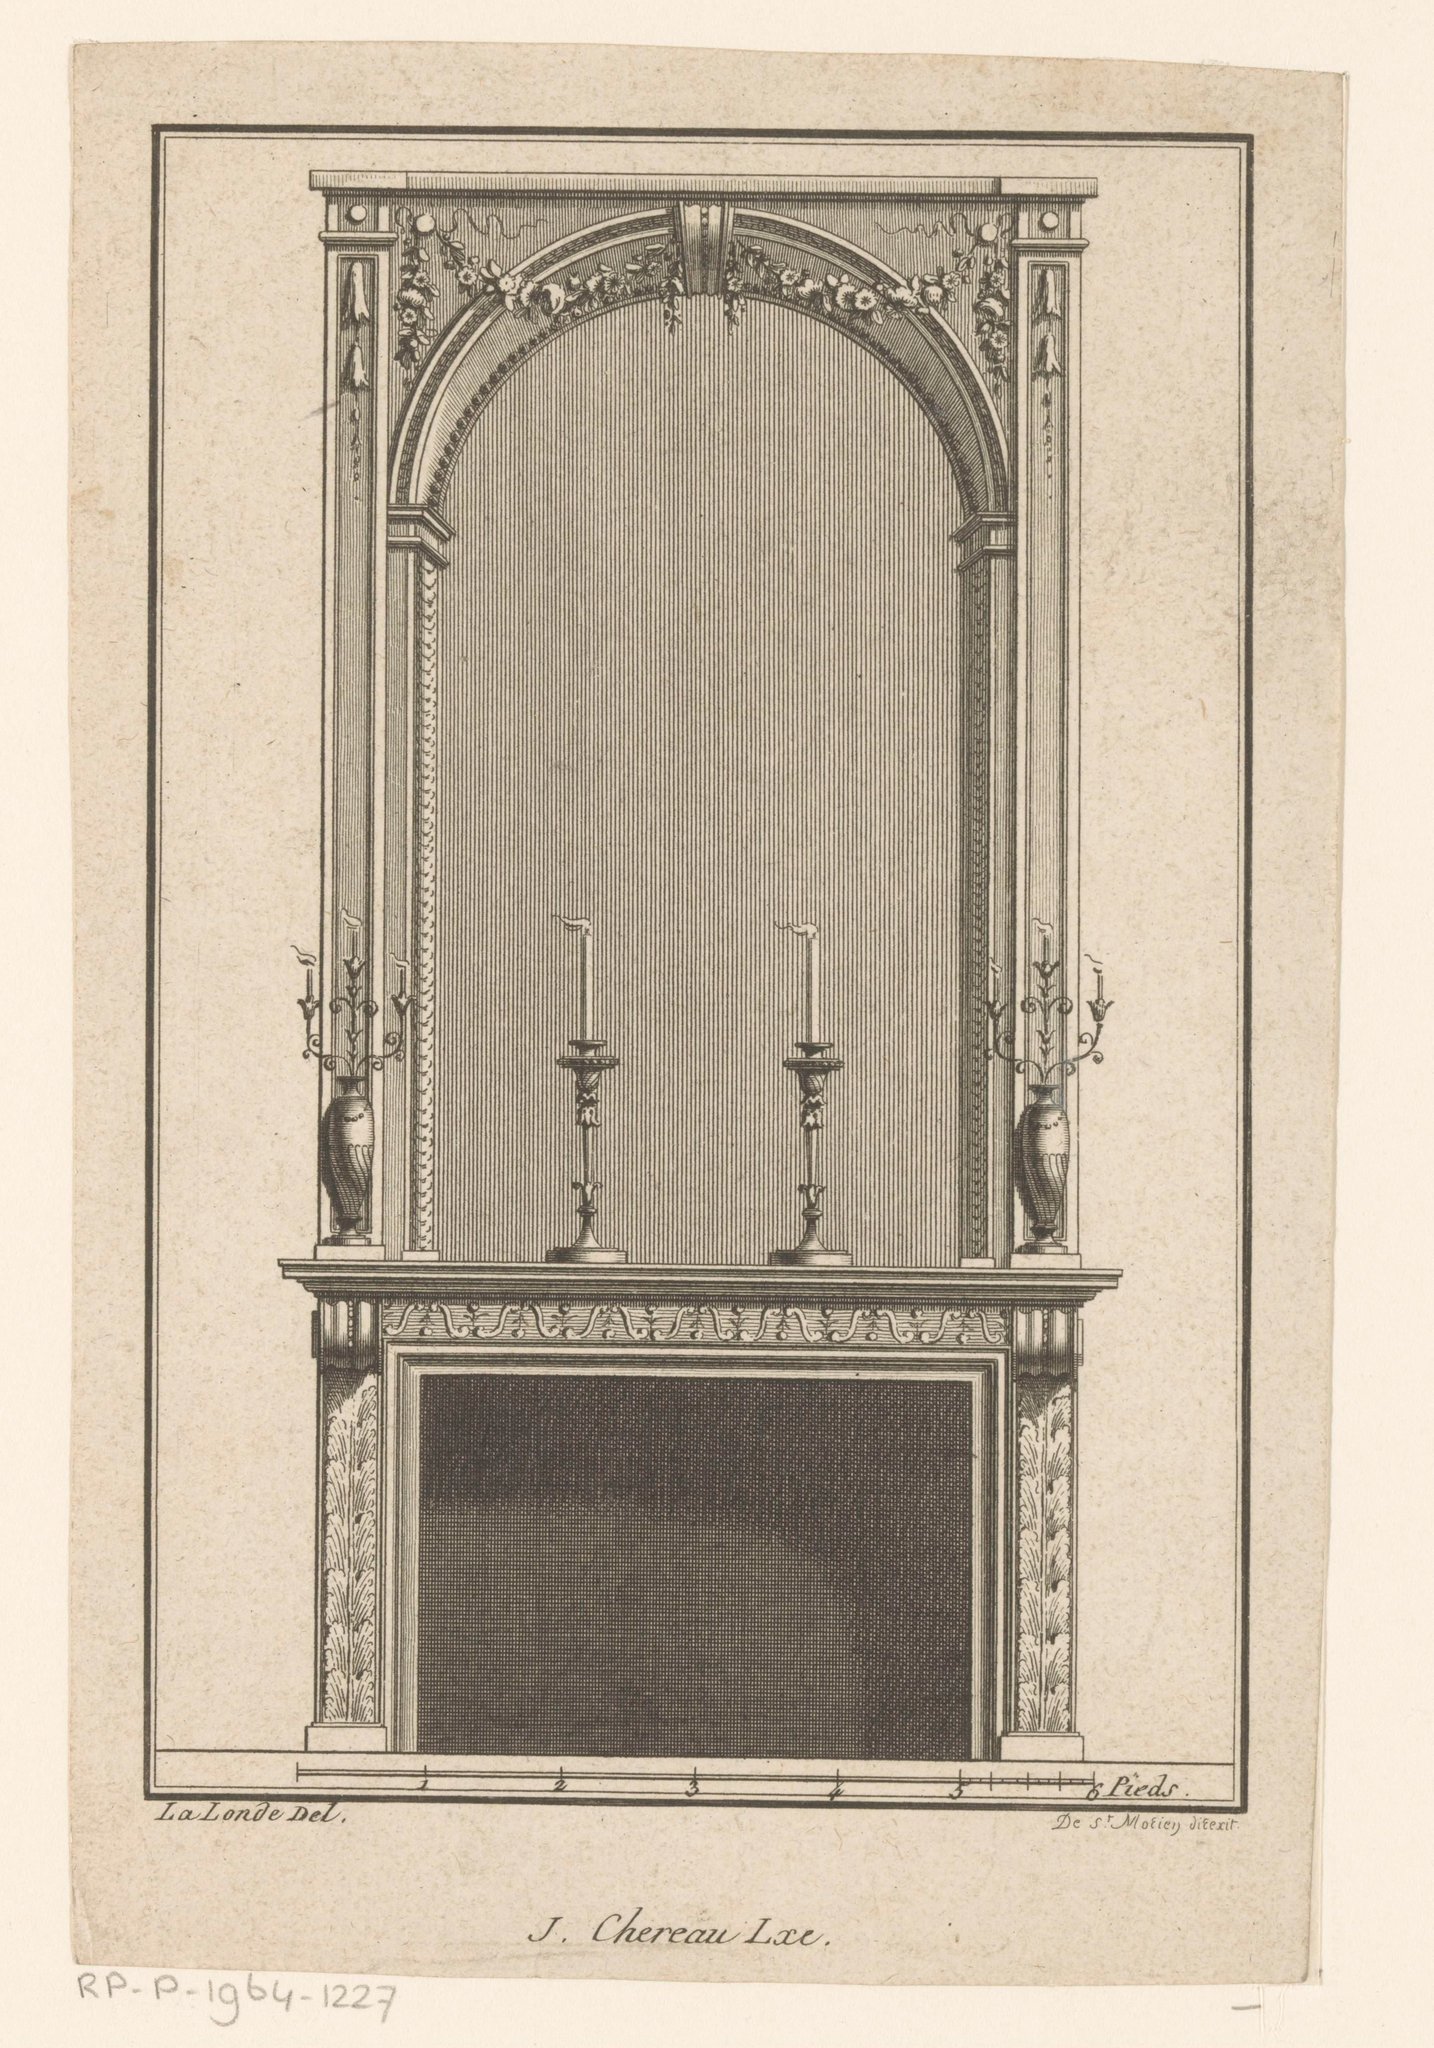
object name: print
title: Schouw met kandelaars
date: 1784-1785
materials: paper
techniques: engraving, etching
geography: paris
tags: chandelier, candelabrum, open hearth, fire-place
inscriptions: collector's mark: Lugt 2760, collector's mark: Lugt 2228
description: Een geornamenteerde schouw met guirlandes, bladmotieven, twee kandelaars in het midden en twee driearmige kandelaars in de vorm van vazen links en rechts.